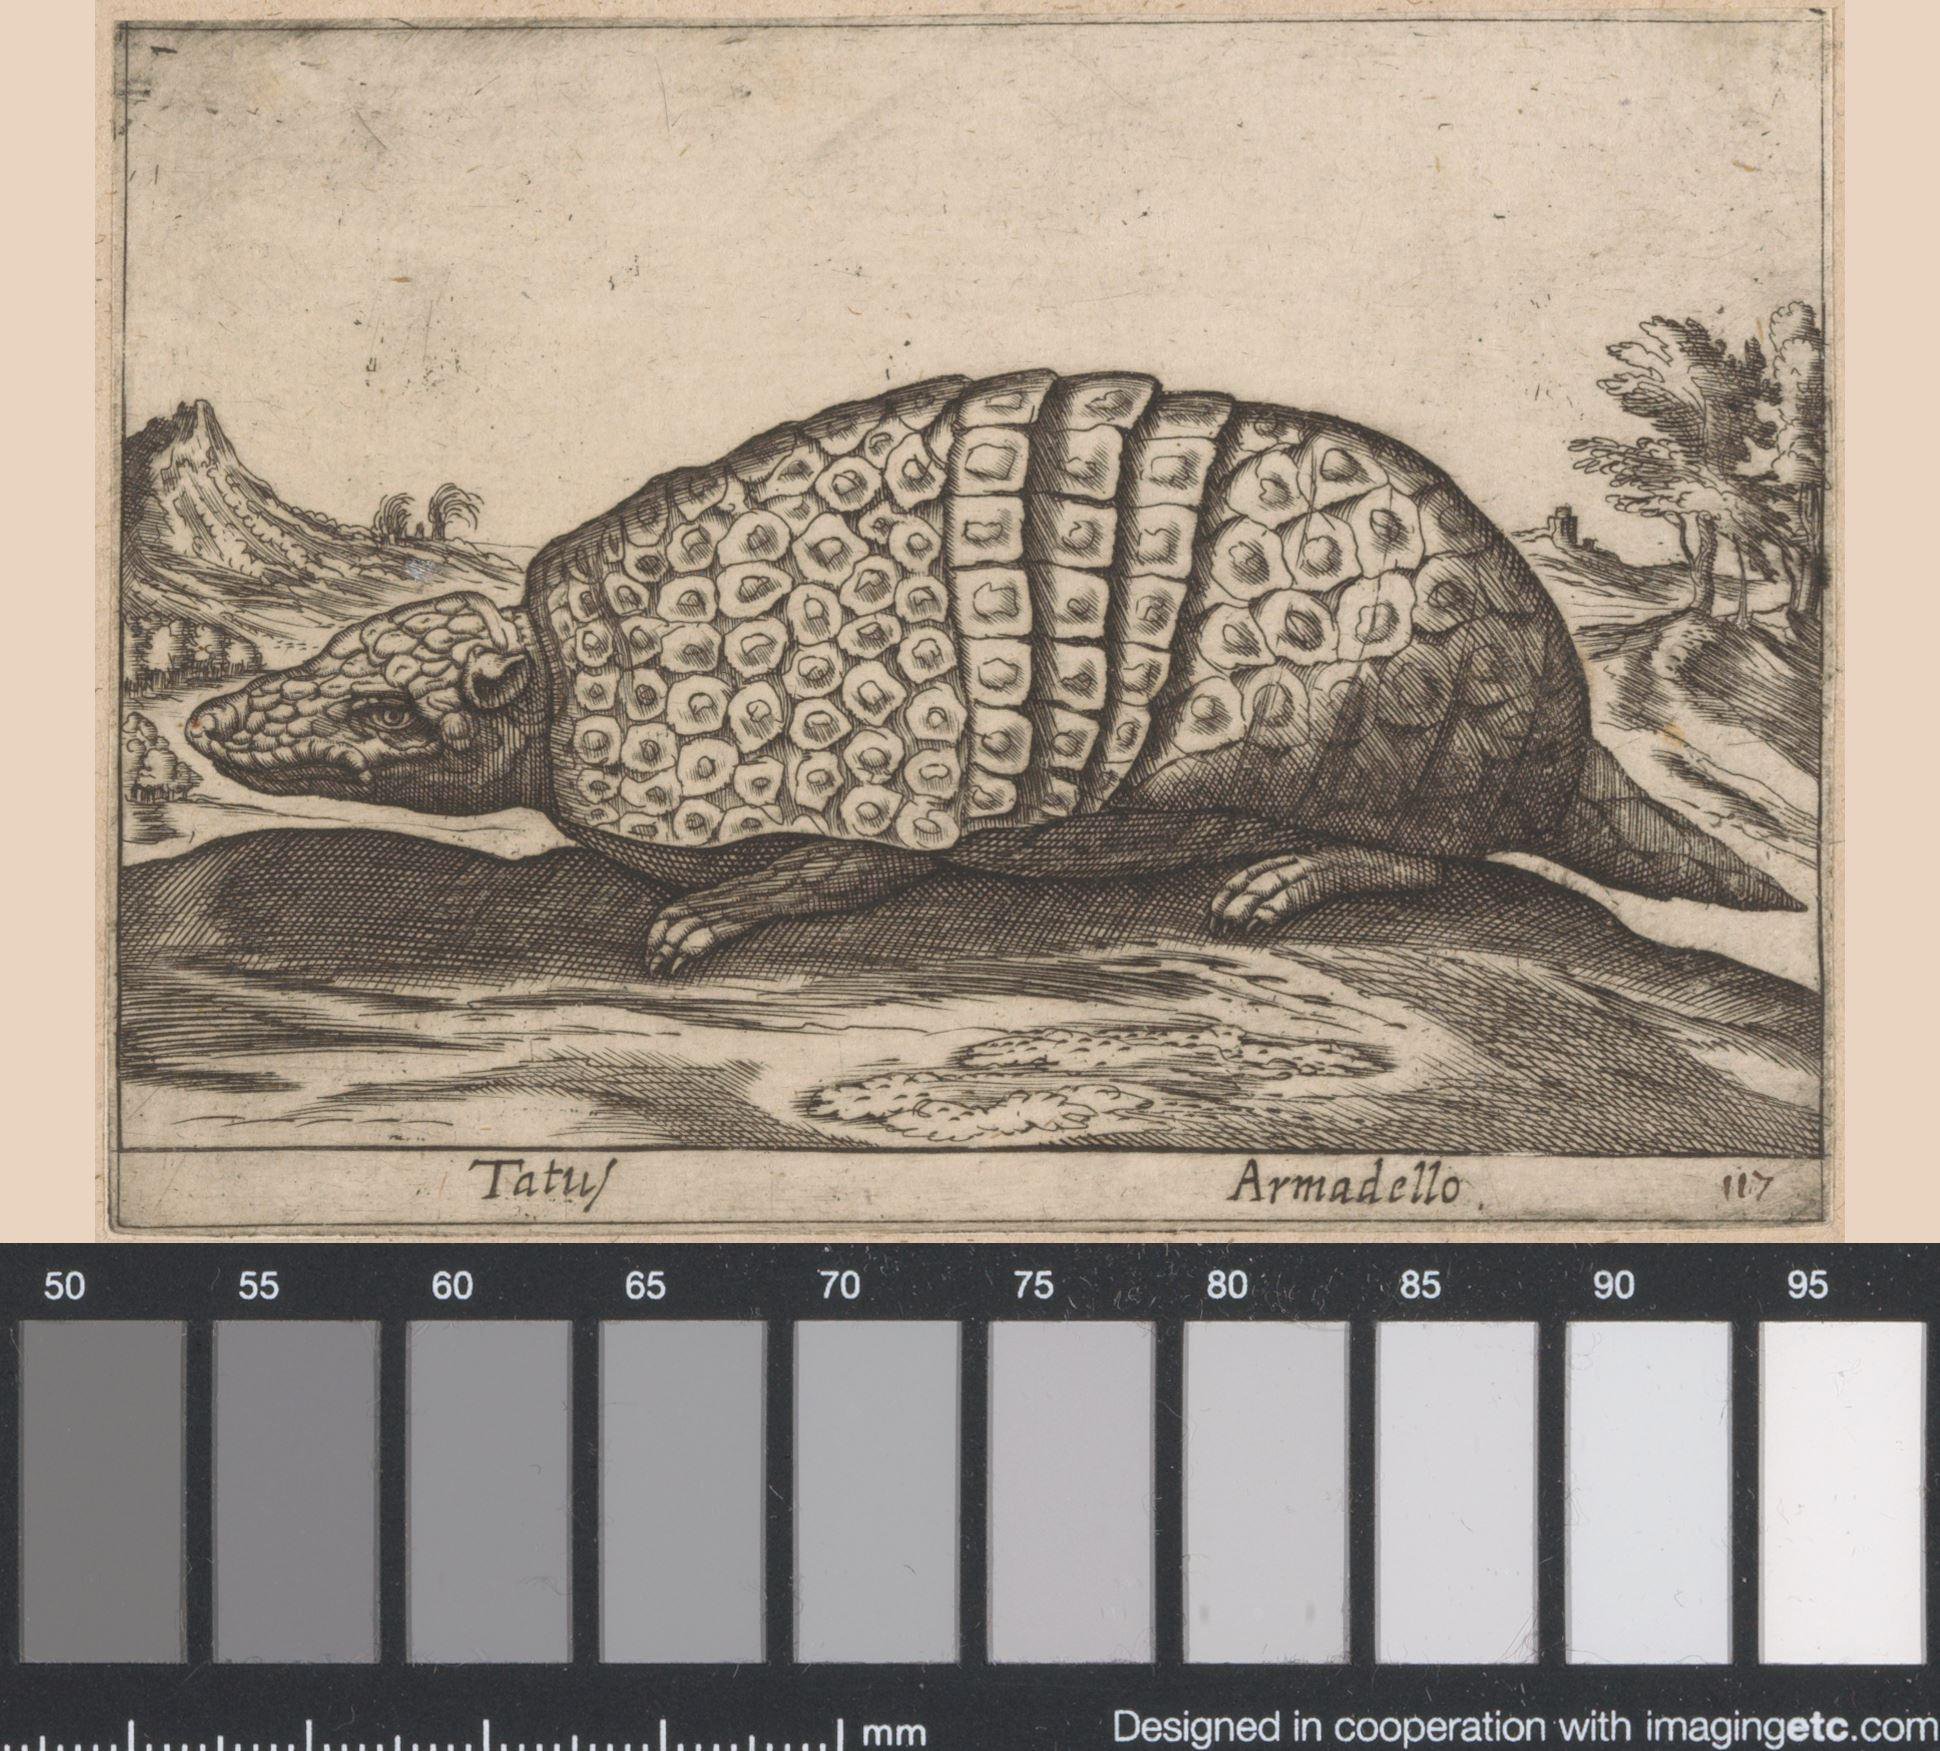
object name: print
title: Gordeldier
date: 1565-1630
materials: paper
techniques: etching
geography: italy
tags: other mammals: armadillo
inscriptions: collector's mark: Lugt 11, number: ‘117’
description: Deze prent maakt deel uit van een reeks prenten van dieren door Antonio Tempesta. Bekend is dat een tweede staat (met nummering) van deze serie is uitgegeven door Giovanni Giacomo de' Rossi in 1650. Onbekend is wie de eerste staat heeft uitgegeven en wanneer.